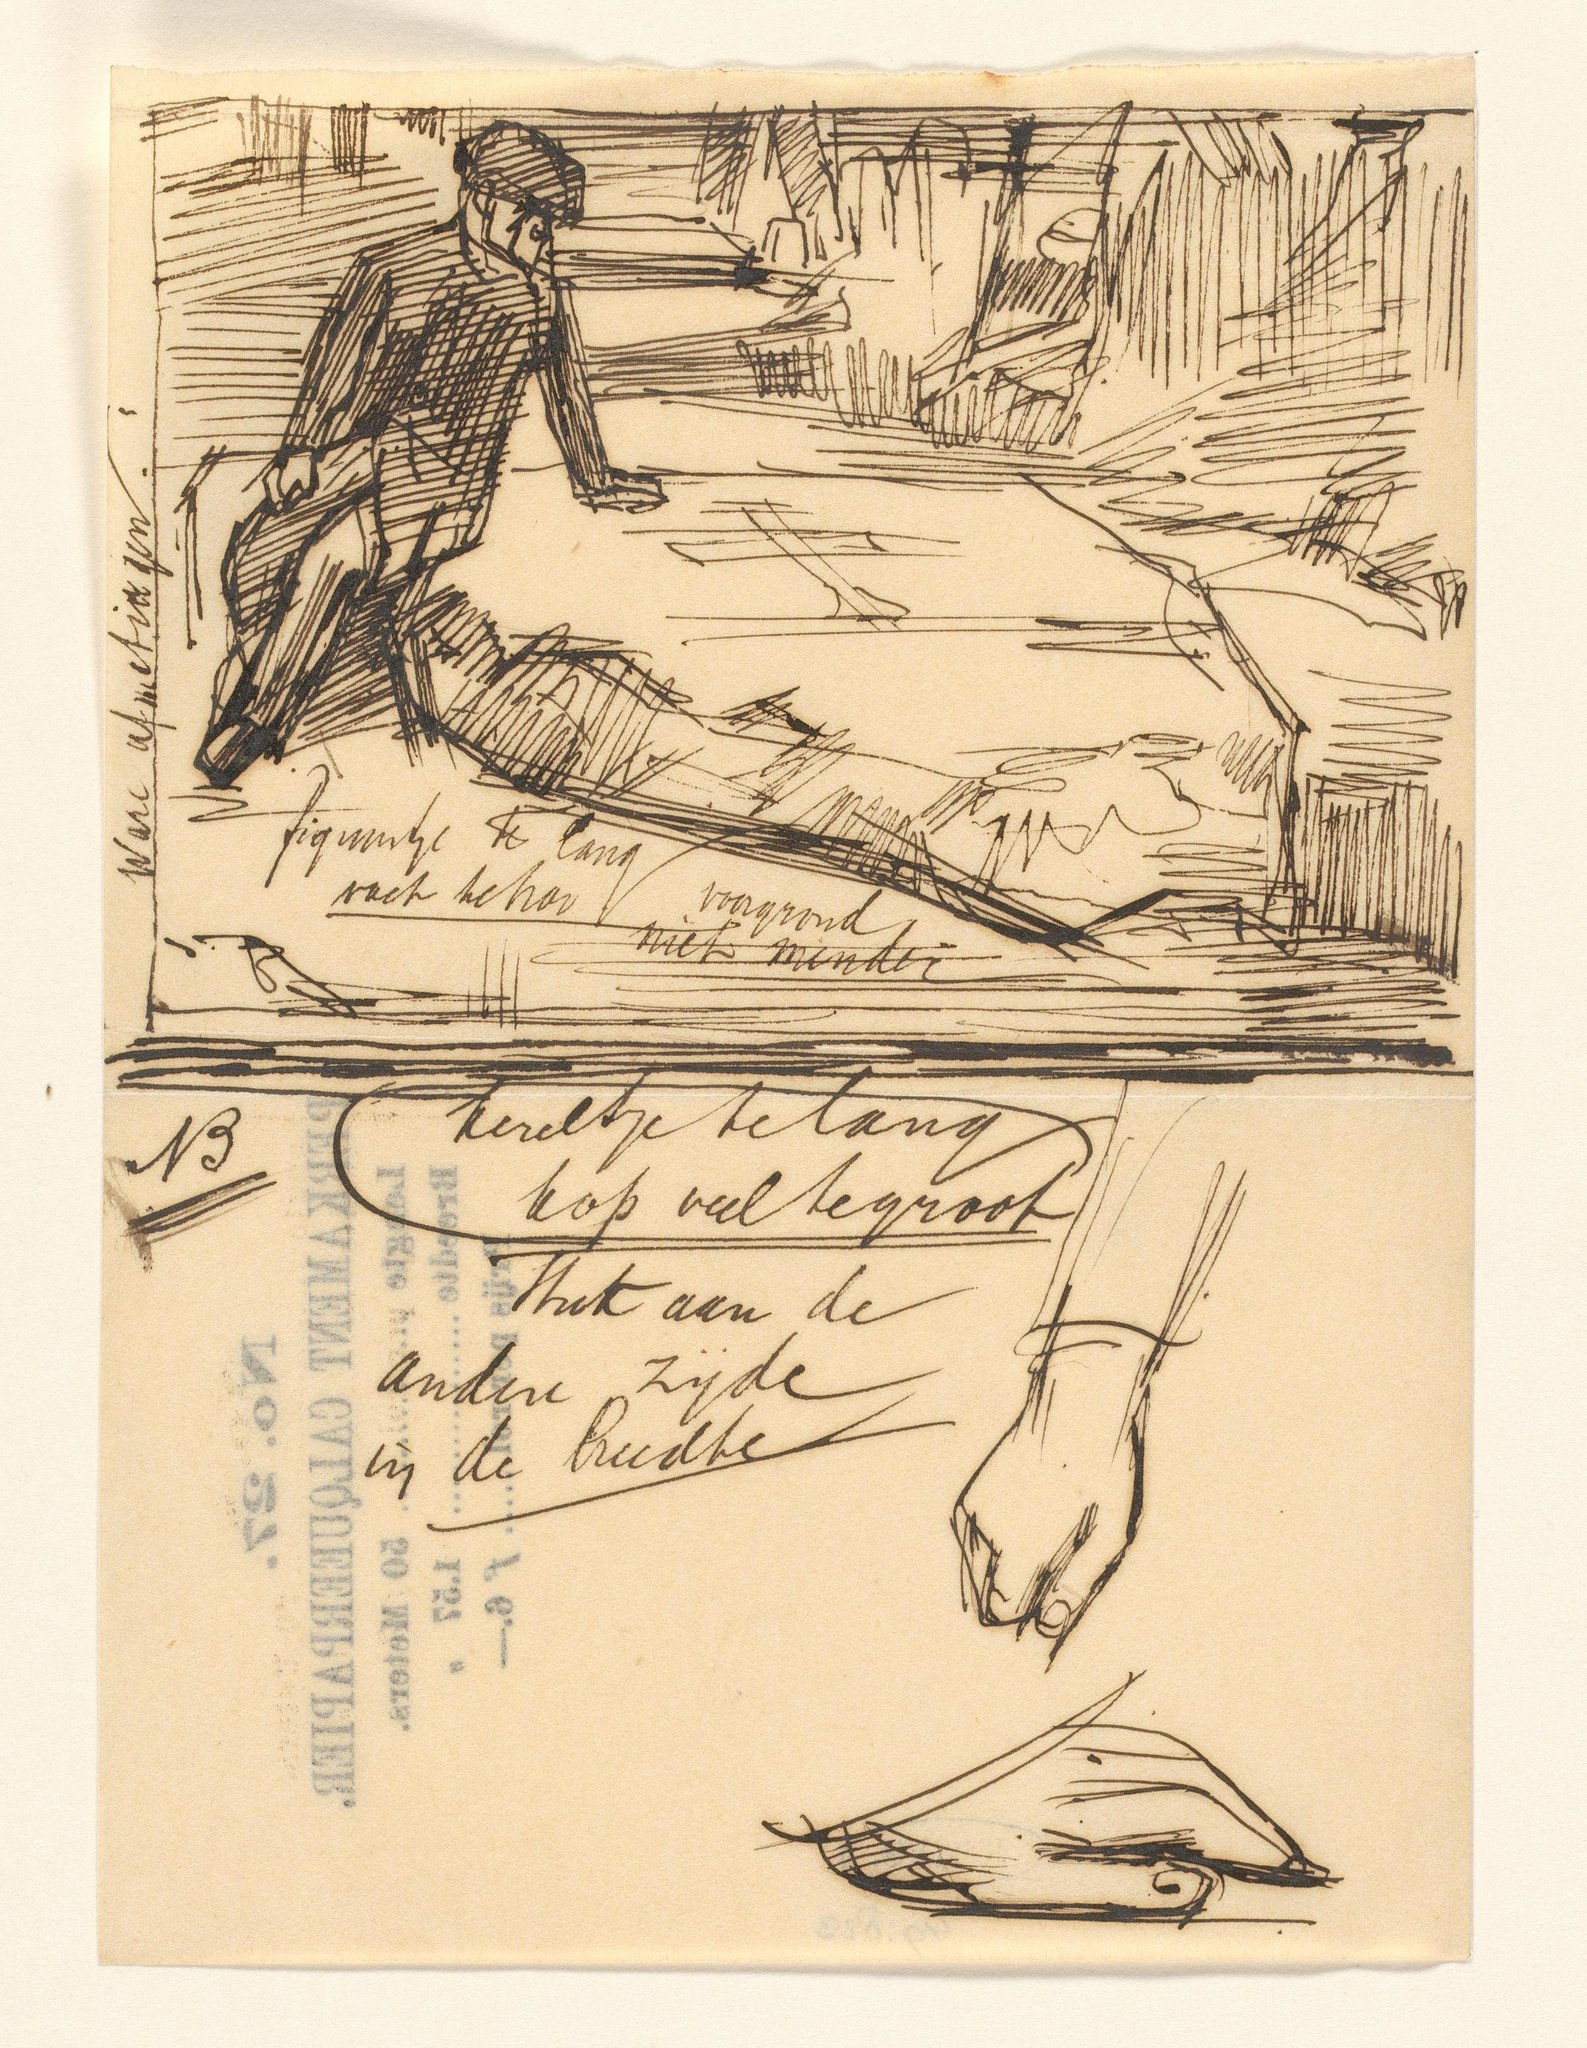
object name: drawing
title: Schetsblad met zittende man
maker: august allebé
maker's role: draughtsman, print maker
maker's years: 1838-1927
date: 1848-1927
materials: ink, paper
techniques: pen